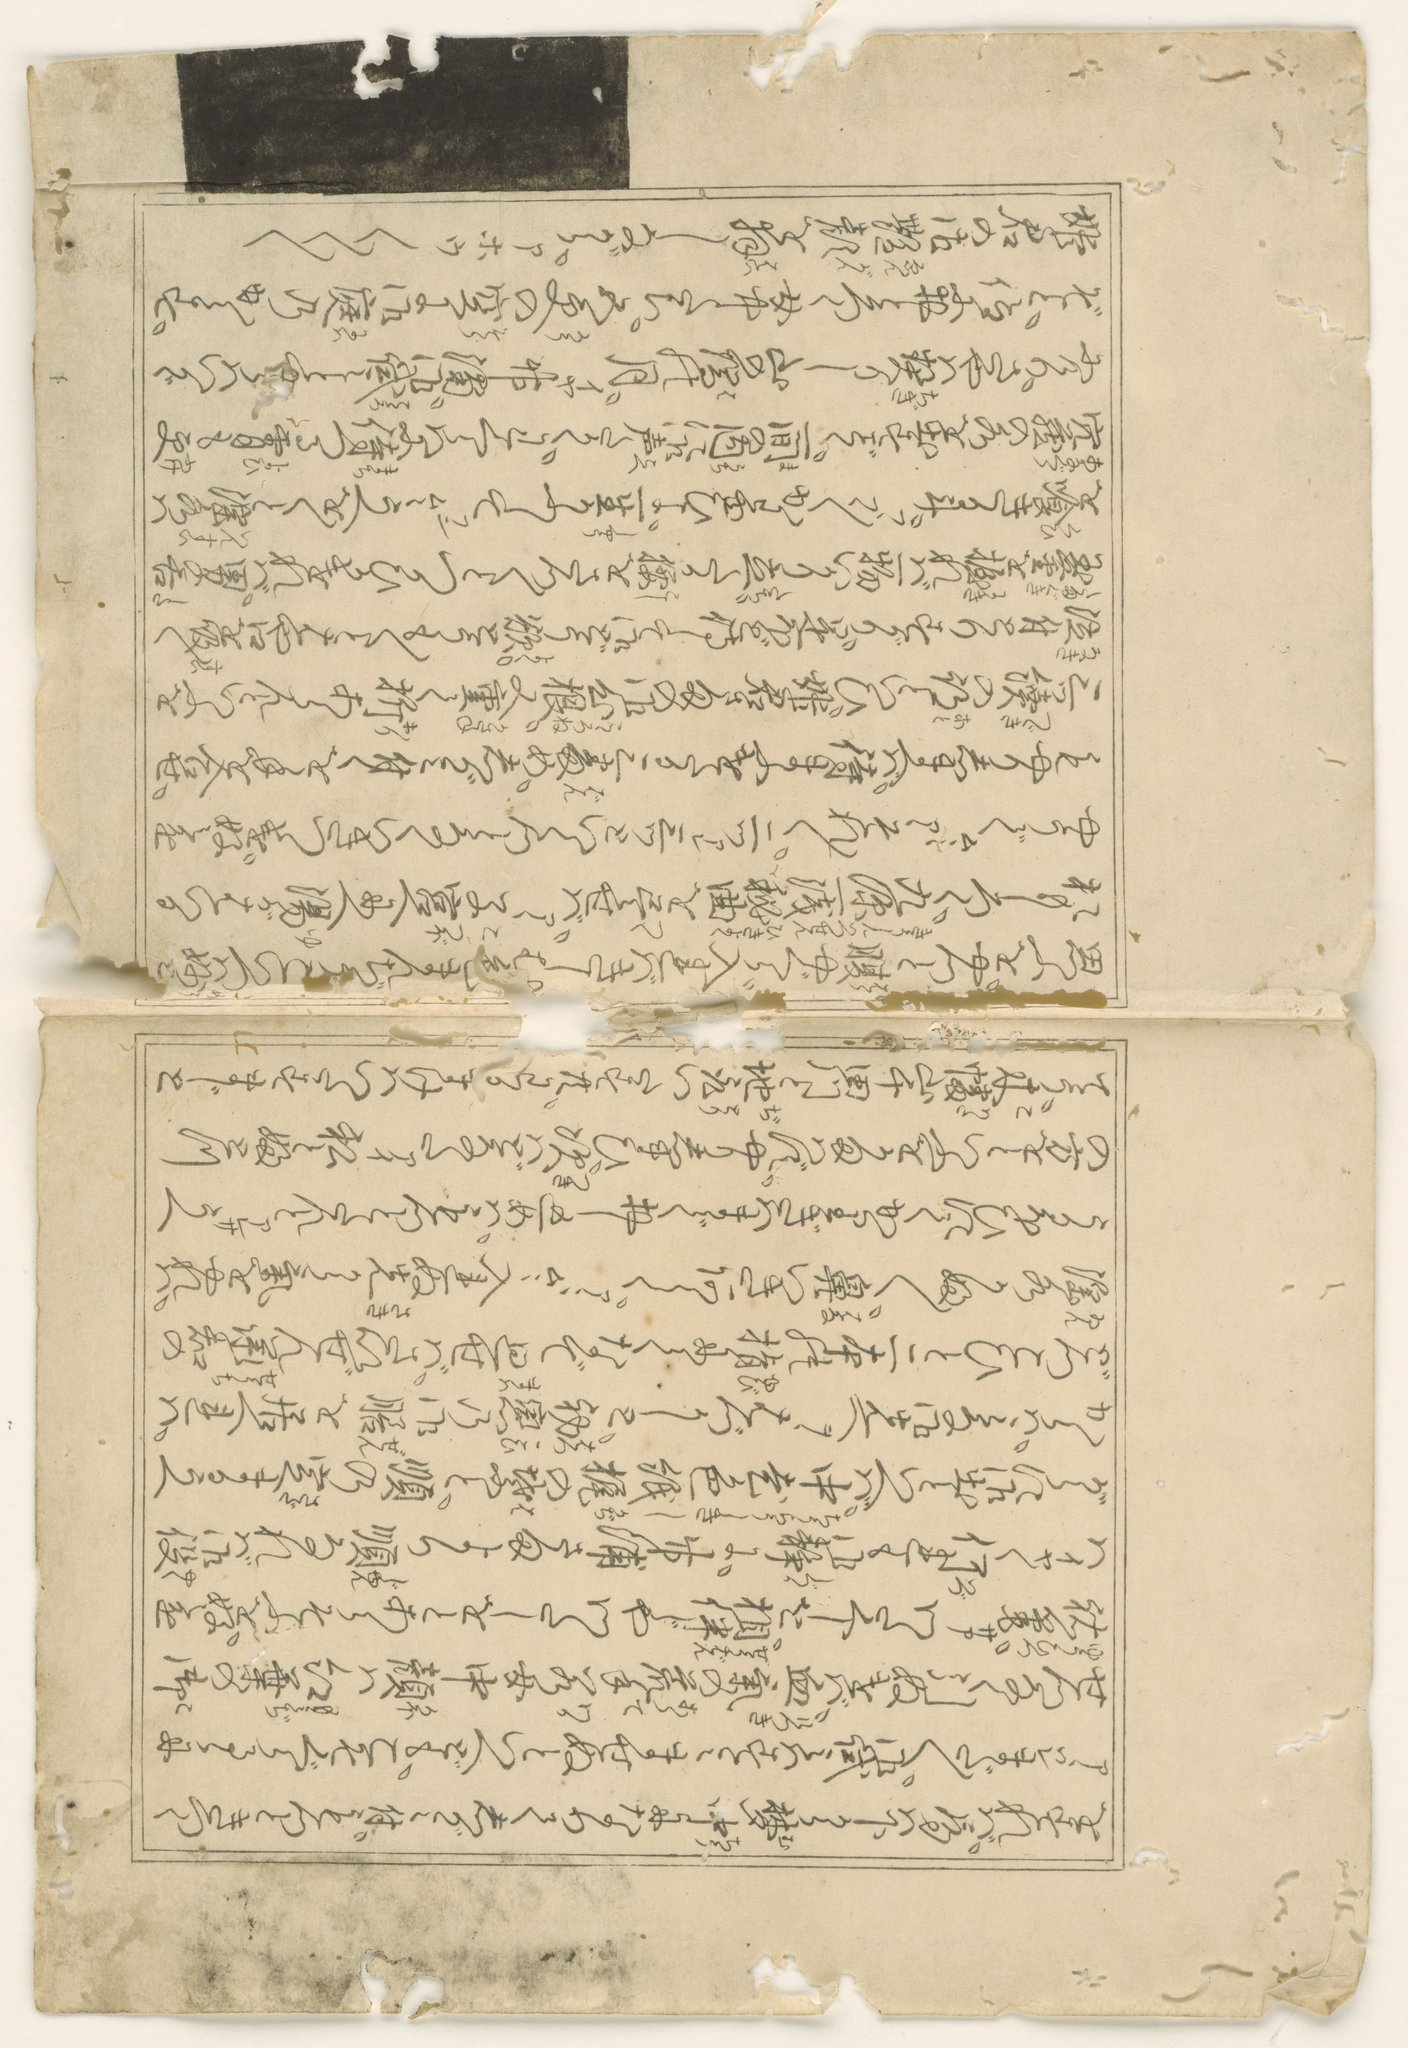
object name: text sheet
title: Negai no itoguchi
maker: kitagawa utamaro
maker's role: print maker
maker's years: 1753-1806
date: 1799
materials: paper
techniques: woodcut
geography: japan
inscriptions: collector's mark: Lugt 2228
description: Laatste tekstpagina van het album Negai no itoguchi (ook wel vertaald met: The prelude to desire). Dubbele pagina Japanse tekst met middenvouw. Zwart vlak in linker marge.